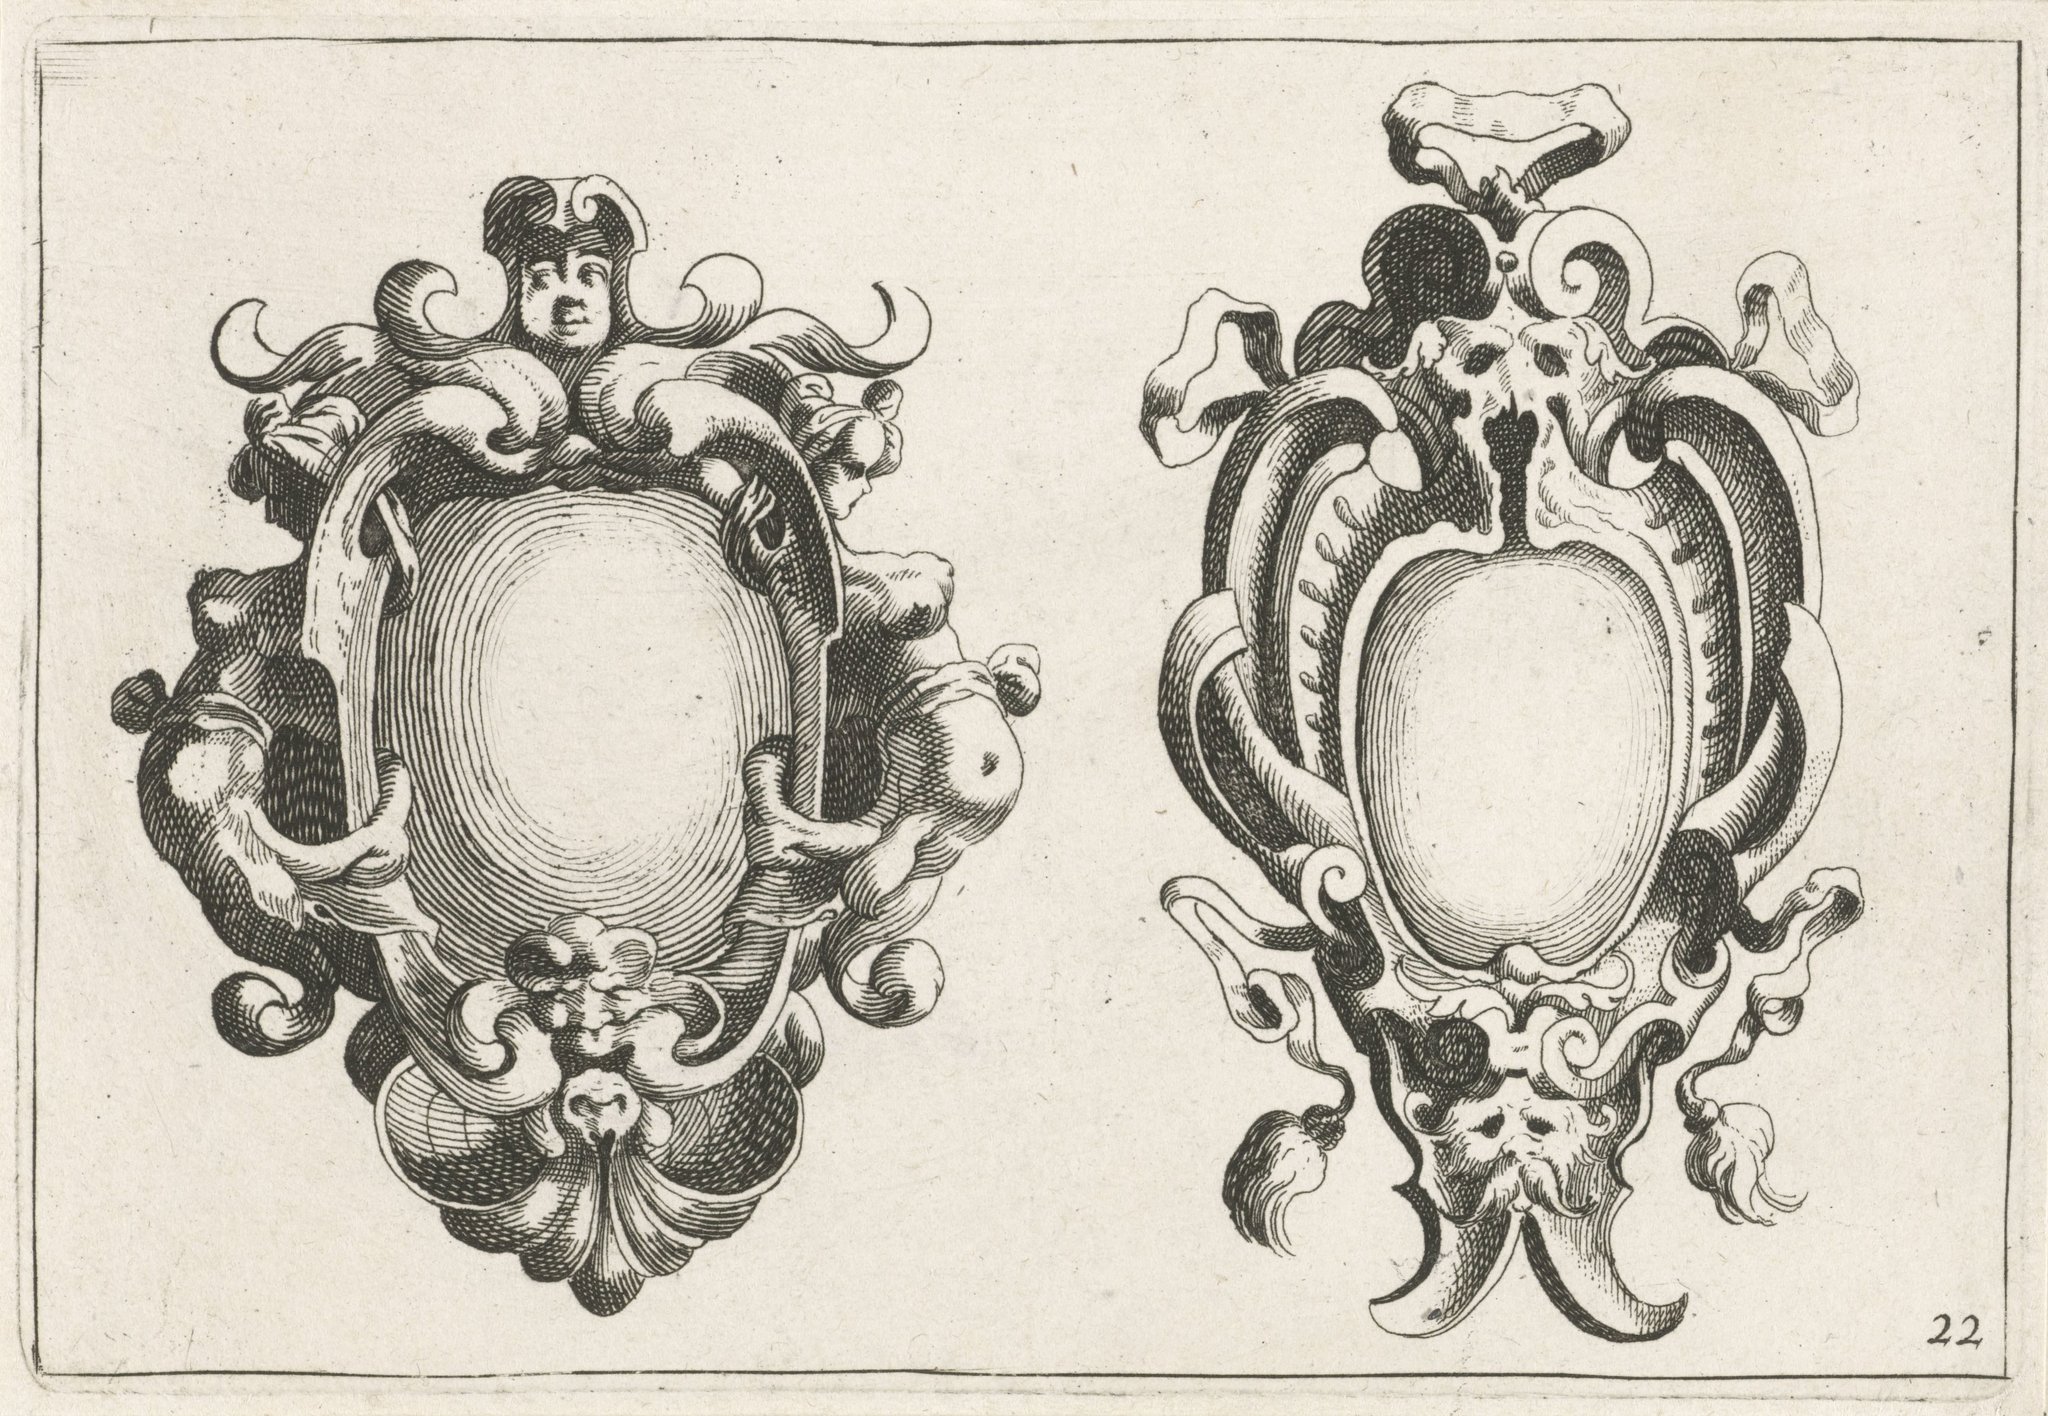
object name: ornament print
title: Differents Conpartimens et Chapiteaux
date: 1657-1685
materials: paper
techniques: engraving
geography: paris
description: De cartouche rechts is gedecoreerd met linten. Uit serie van 22 of 29 bladen met cartouches in Italiaanse kwabstijl, vierde editie.